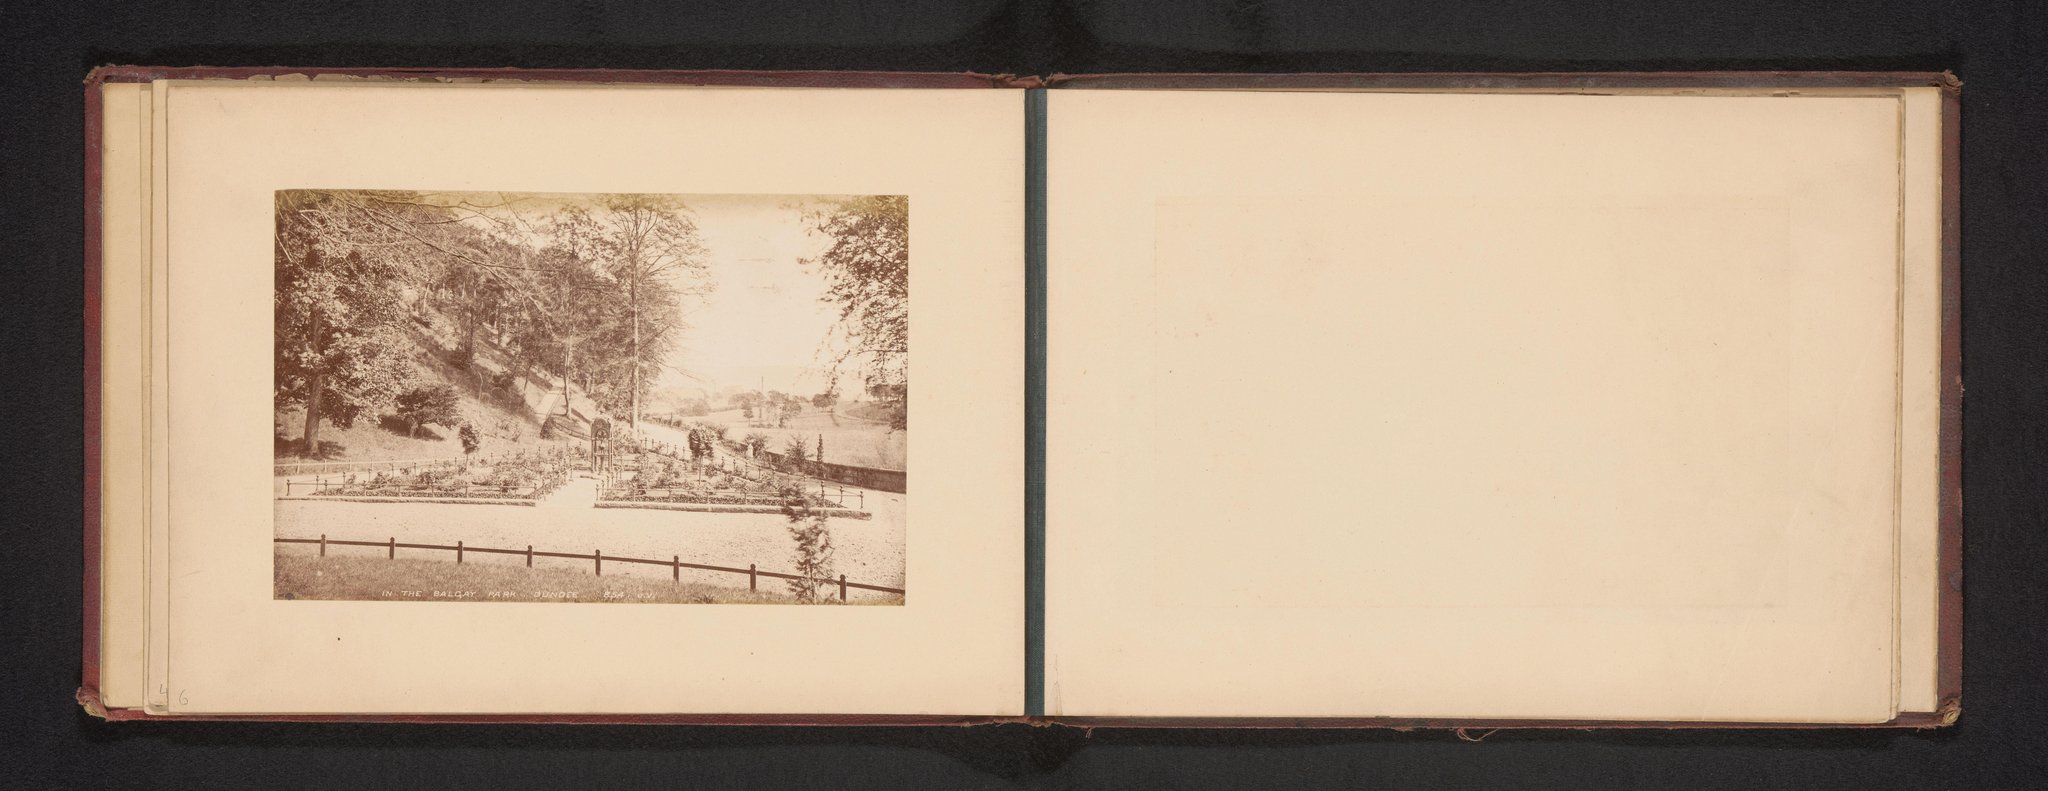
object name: photograph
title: In the Balcay Park, Dundee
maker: james valentine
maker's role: fotograaf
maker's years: 1815-1880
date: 1872-1877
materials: photographic support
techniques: albumen print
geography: dundee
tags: park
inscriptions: number: ‘854 j.v.’